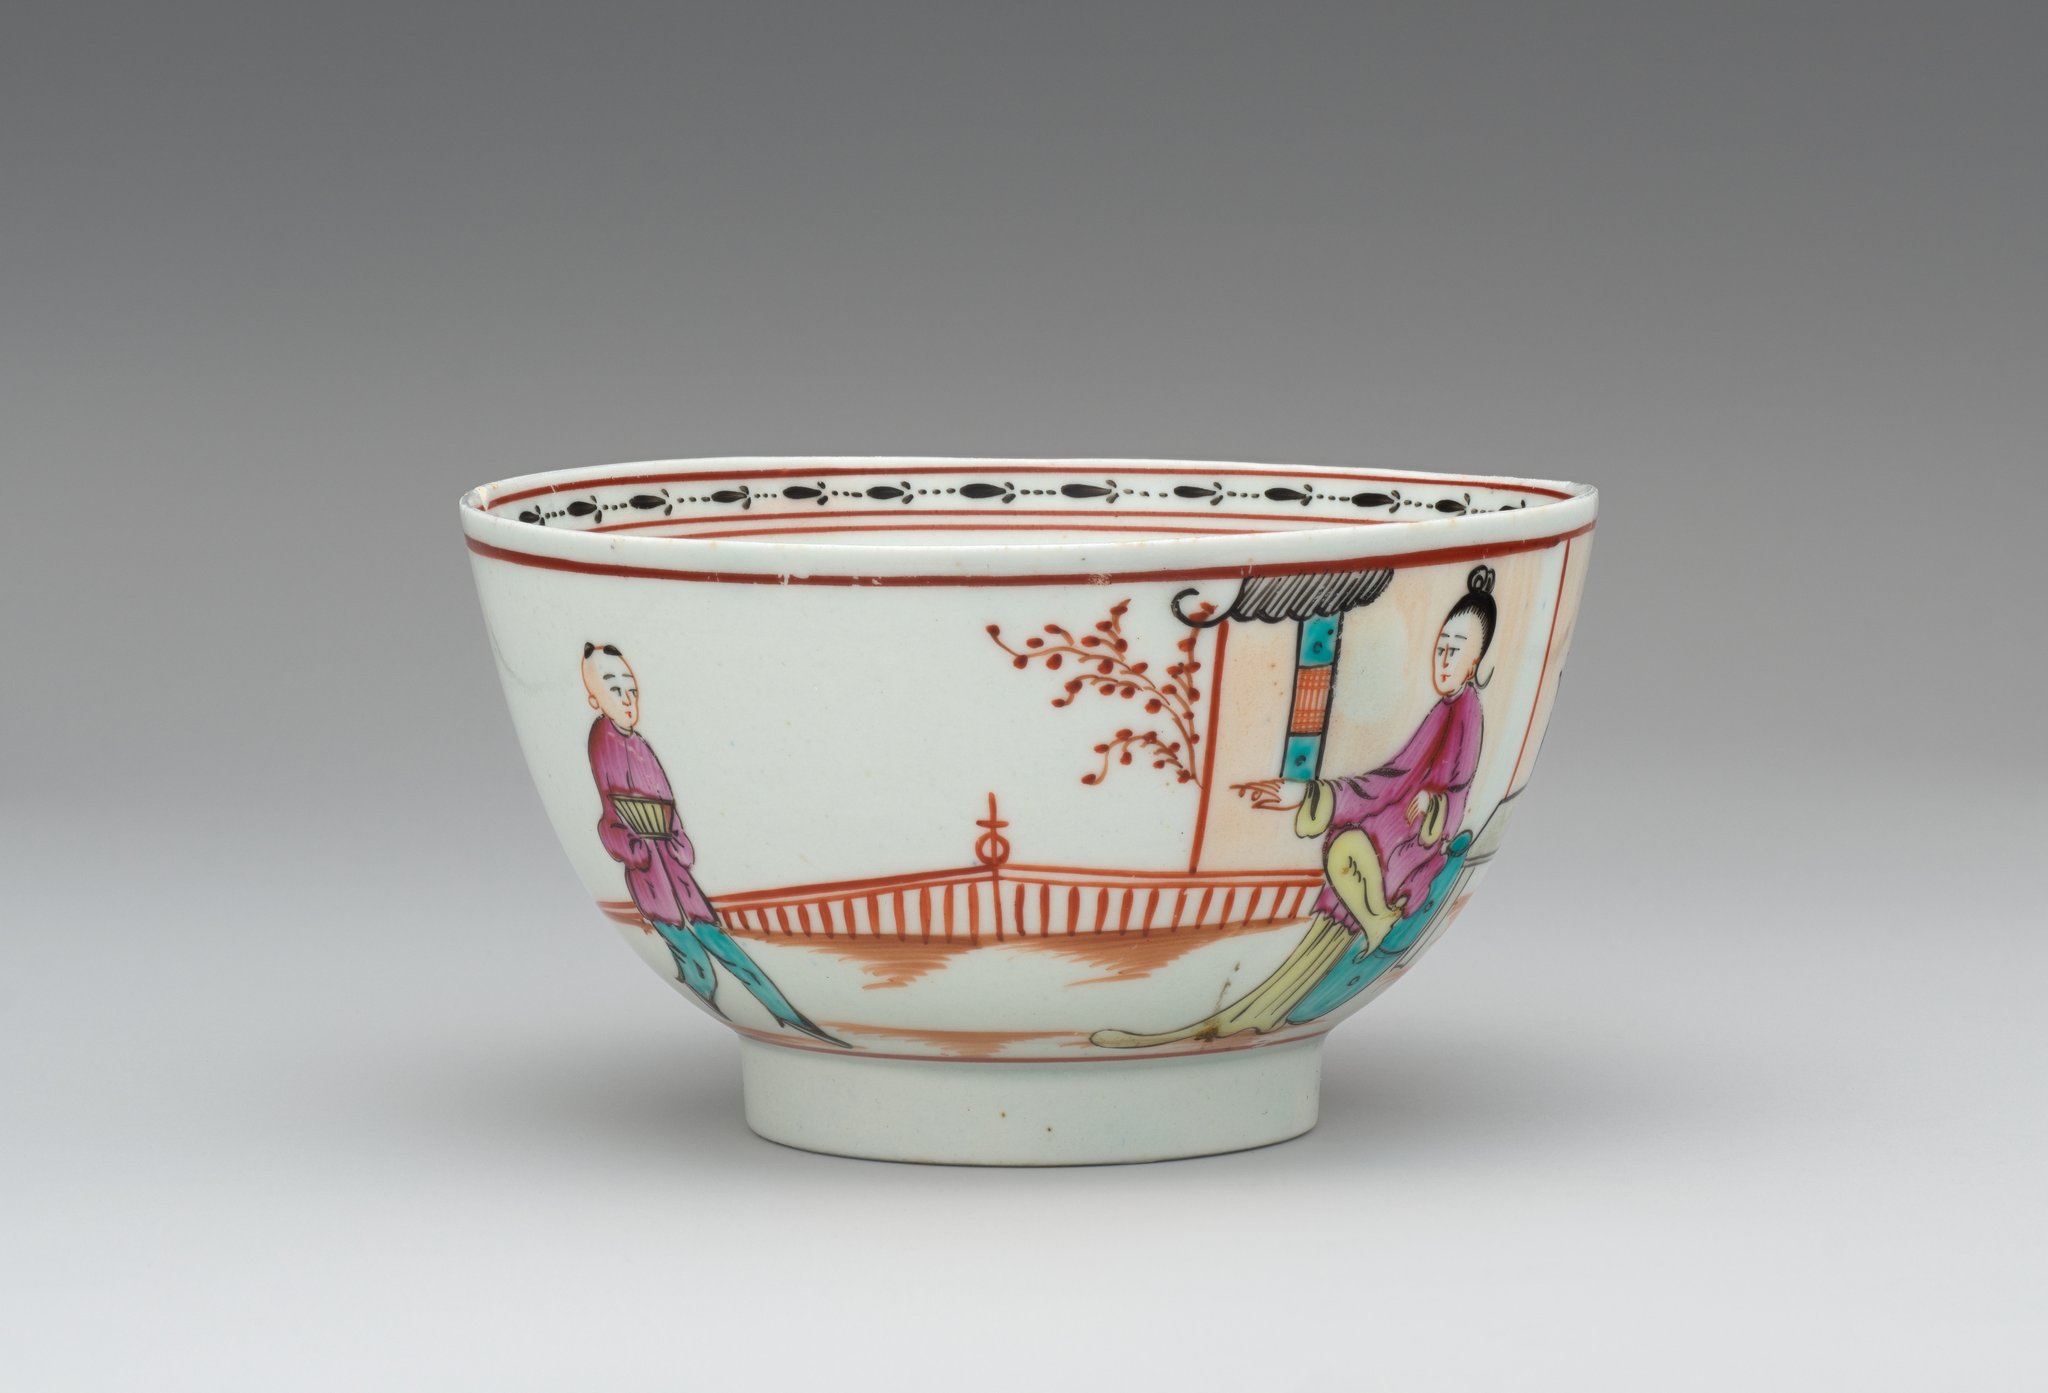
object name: sugar bowl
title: Sugar bowl (?) (part of a service)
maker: lowestoft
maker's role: factory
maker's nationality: british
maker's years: 1757-1803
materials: soft paste porcelain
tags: men